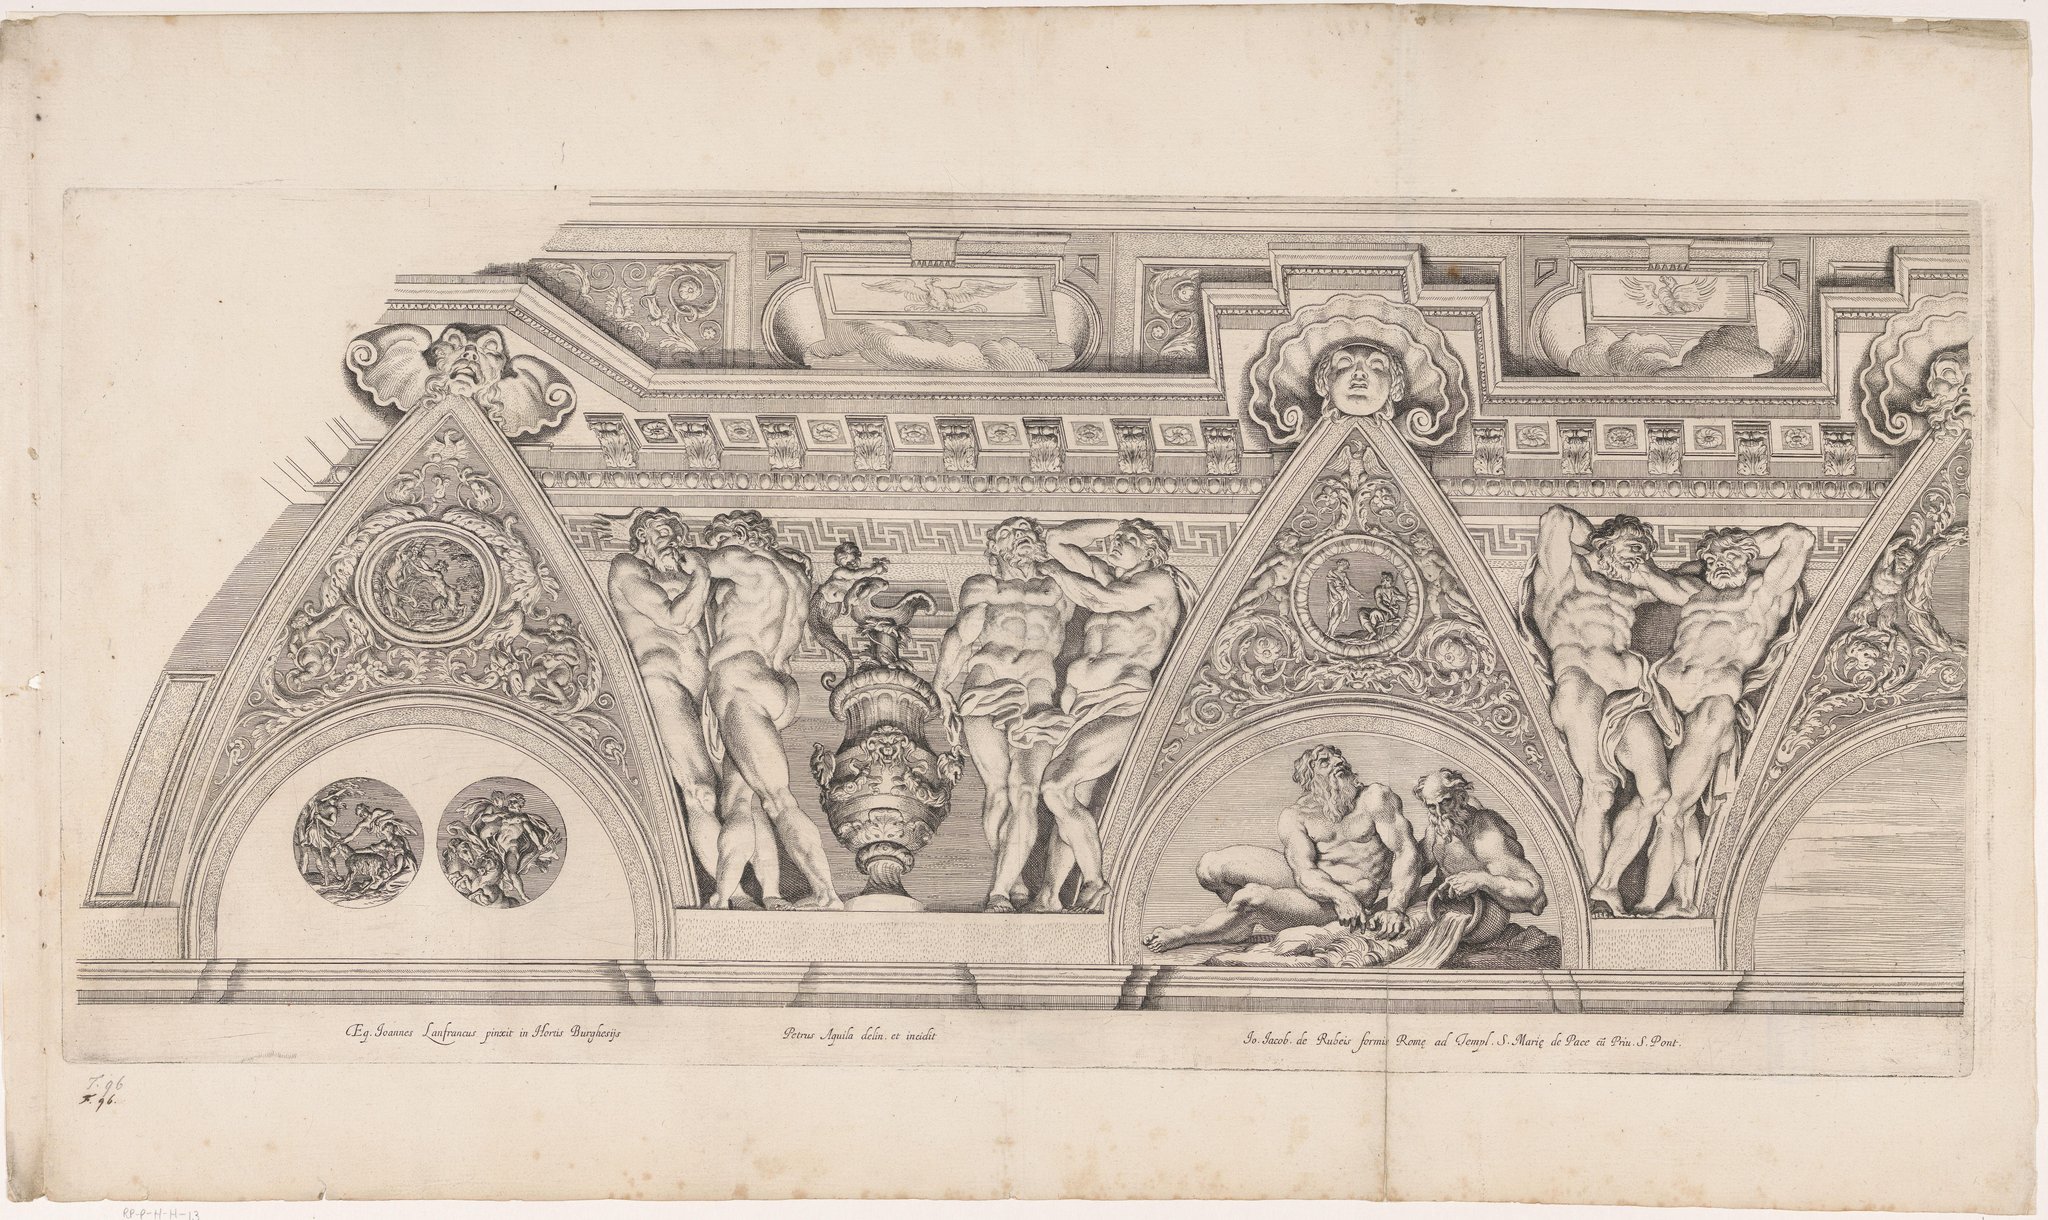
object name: print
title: Plafonddecoratie met Olympische goden, naakte figuren en ornament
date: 1660-1692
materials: paper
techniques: etching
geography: rome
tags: ornaments ~ art, foliage ~ ornament, the olympian gods together: jupiter, juno, neptune, ceres, apollo, diana, mars, venus, mercury, minerva, vulcan, vesta (or bacchus), caryatids ~ architecture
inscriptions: collector's mark: Lugt 11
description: Deel van de plafonddecoratie door Giovanni Lanfranco in de Villa Borghese te Rome, met twee lunetten met mythologische voorstellingen en voorstellingen van goden van de Olympus, naakte figuren en ornament.